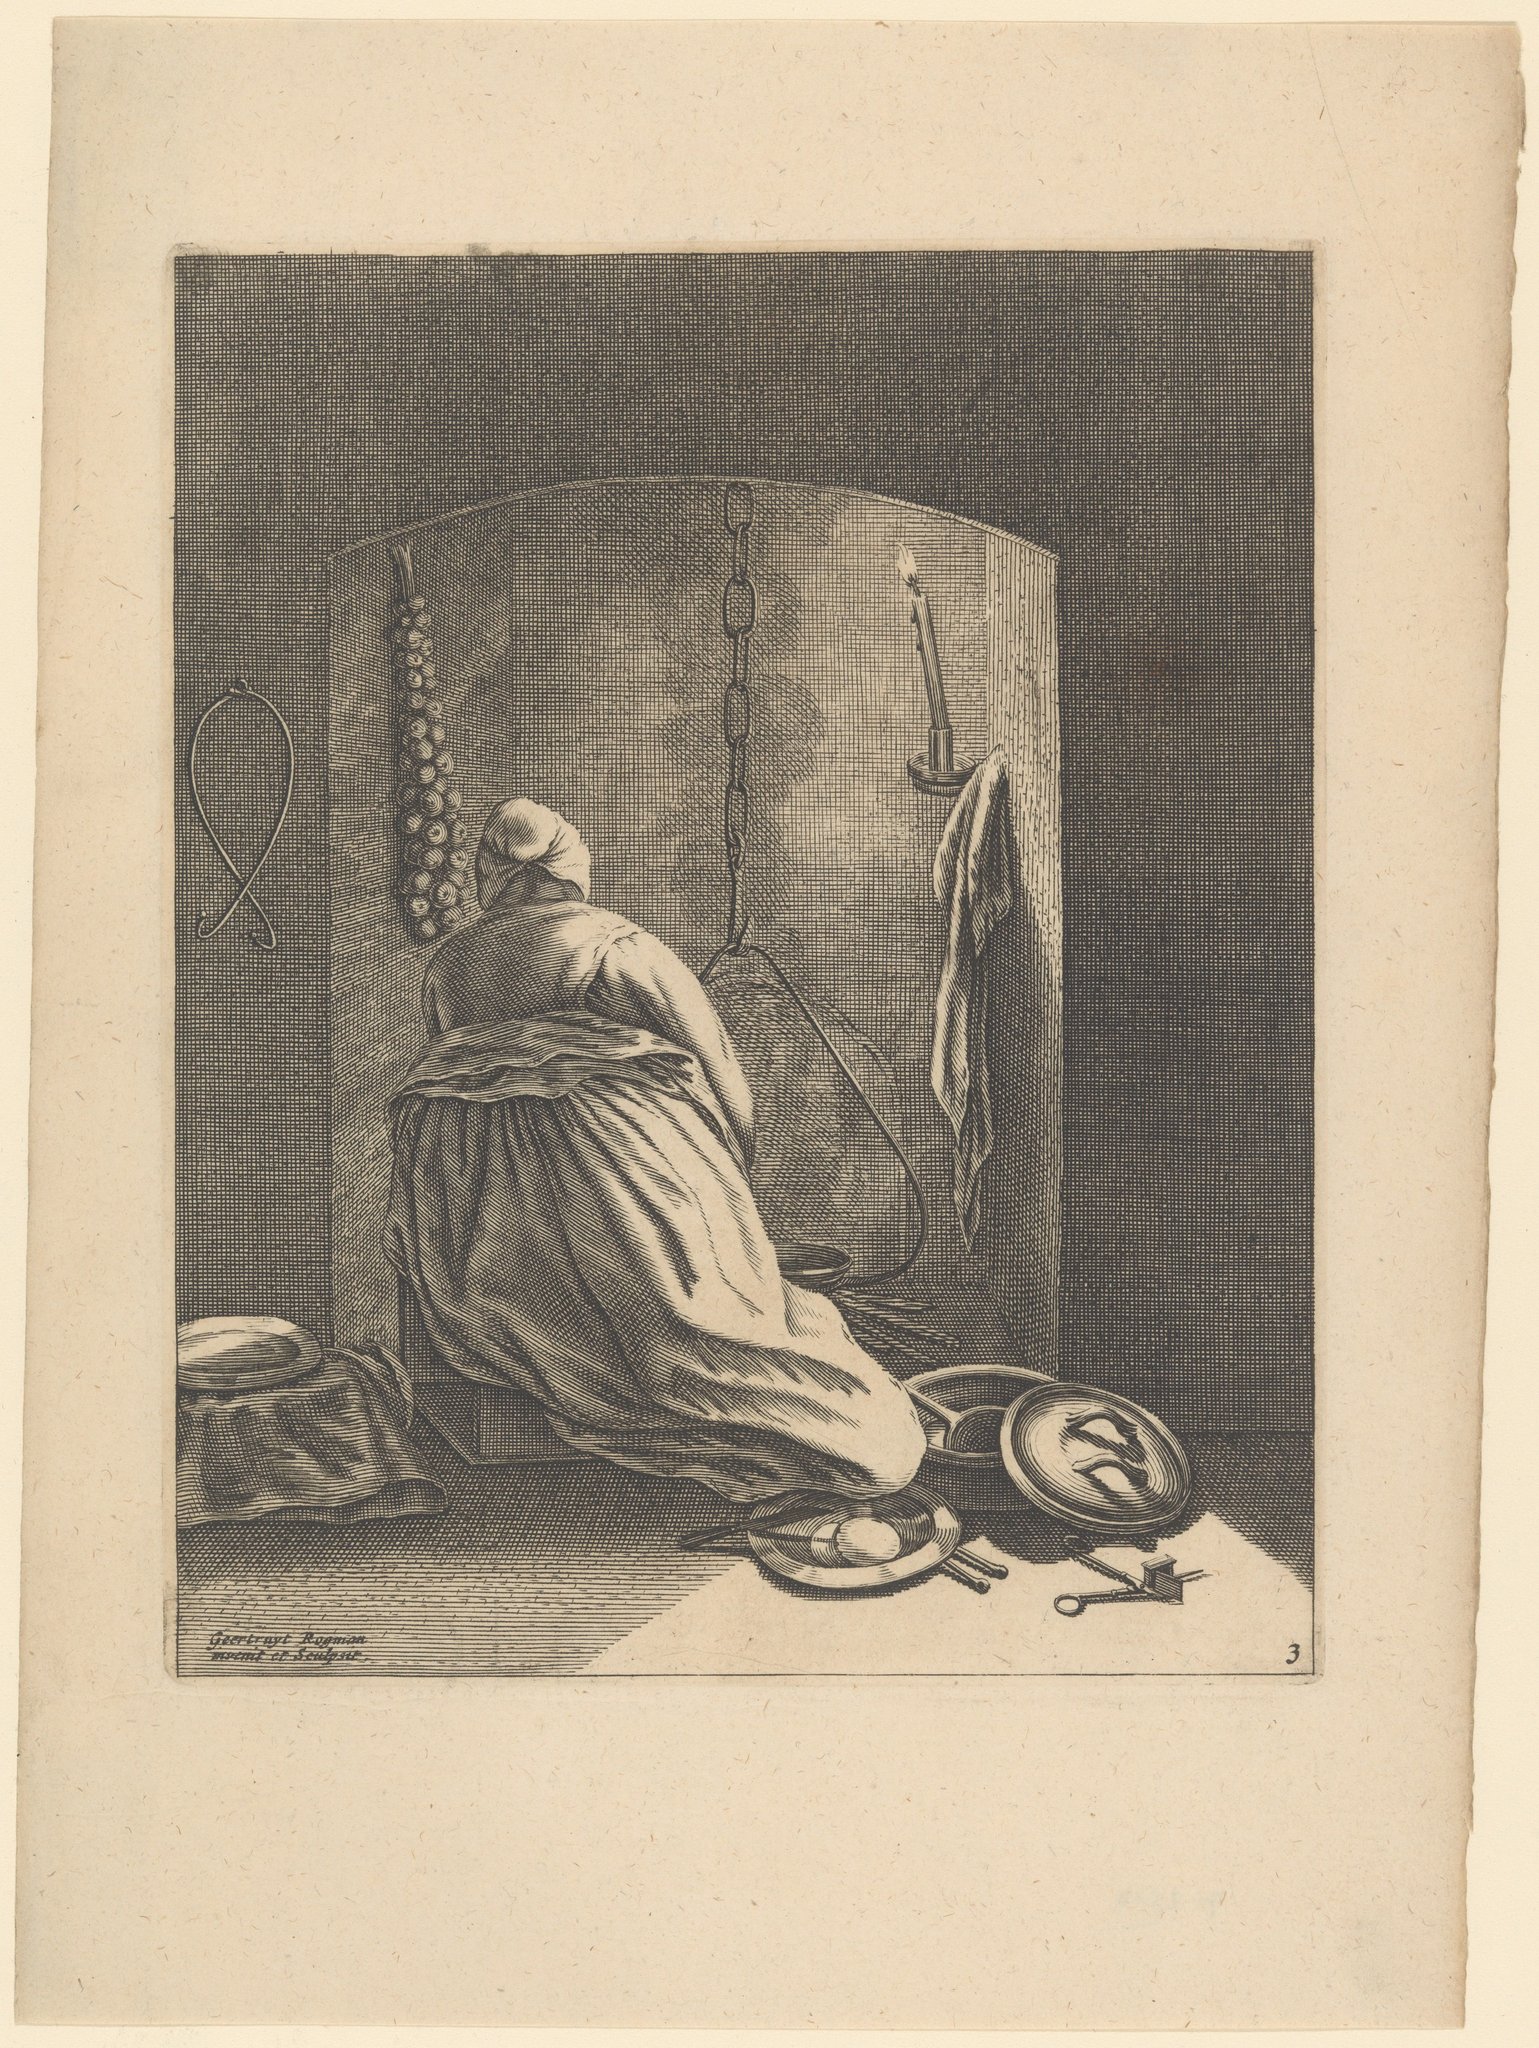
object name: print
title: A Woman Cooking, Plate 3 from "Five Feminine Occupations"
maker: geertruydt roghman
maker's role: artist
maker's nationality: dutch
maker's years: 1625-1657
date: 1640-1657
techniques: engraving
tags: kitchens,women,servants,cooking